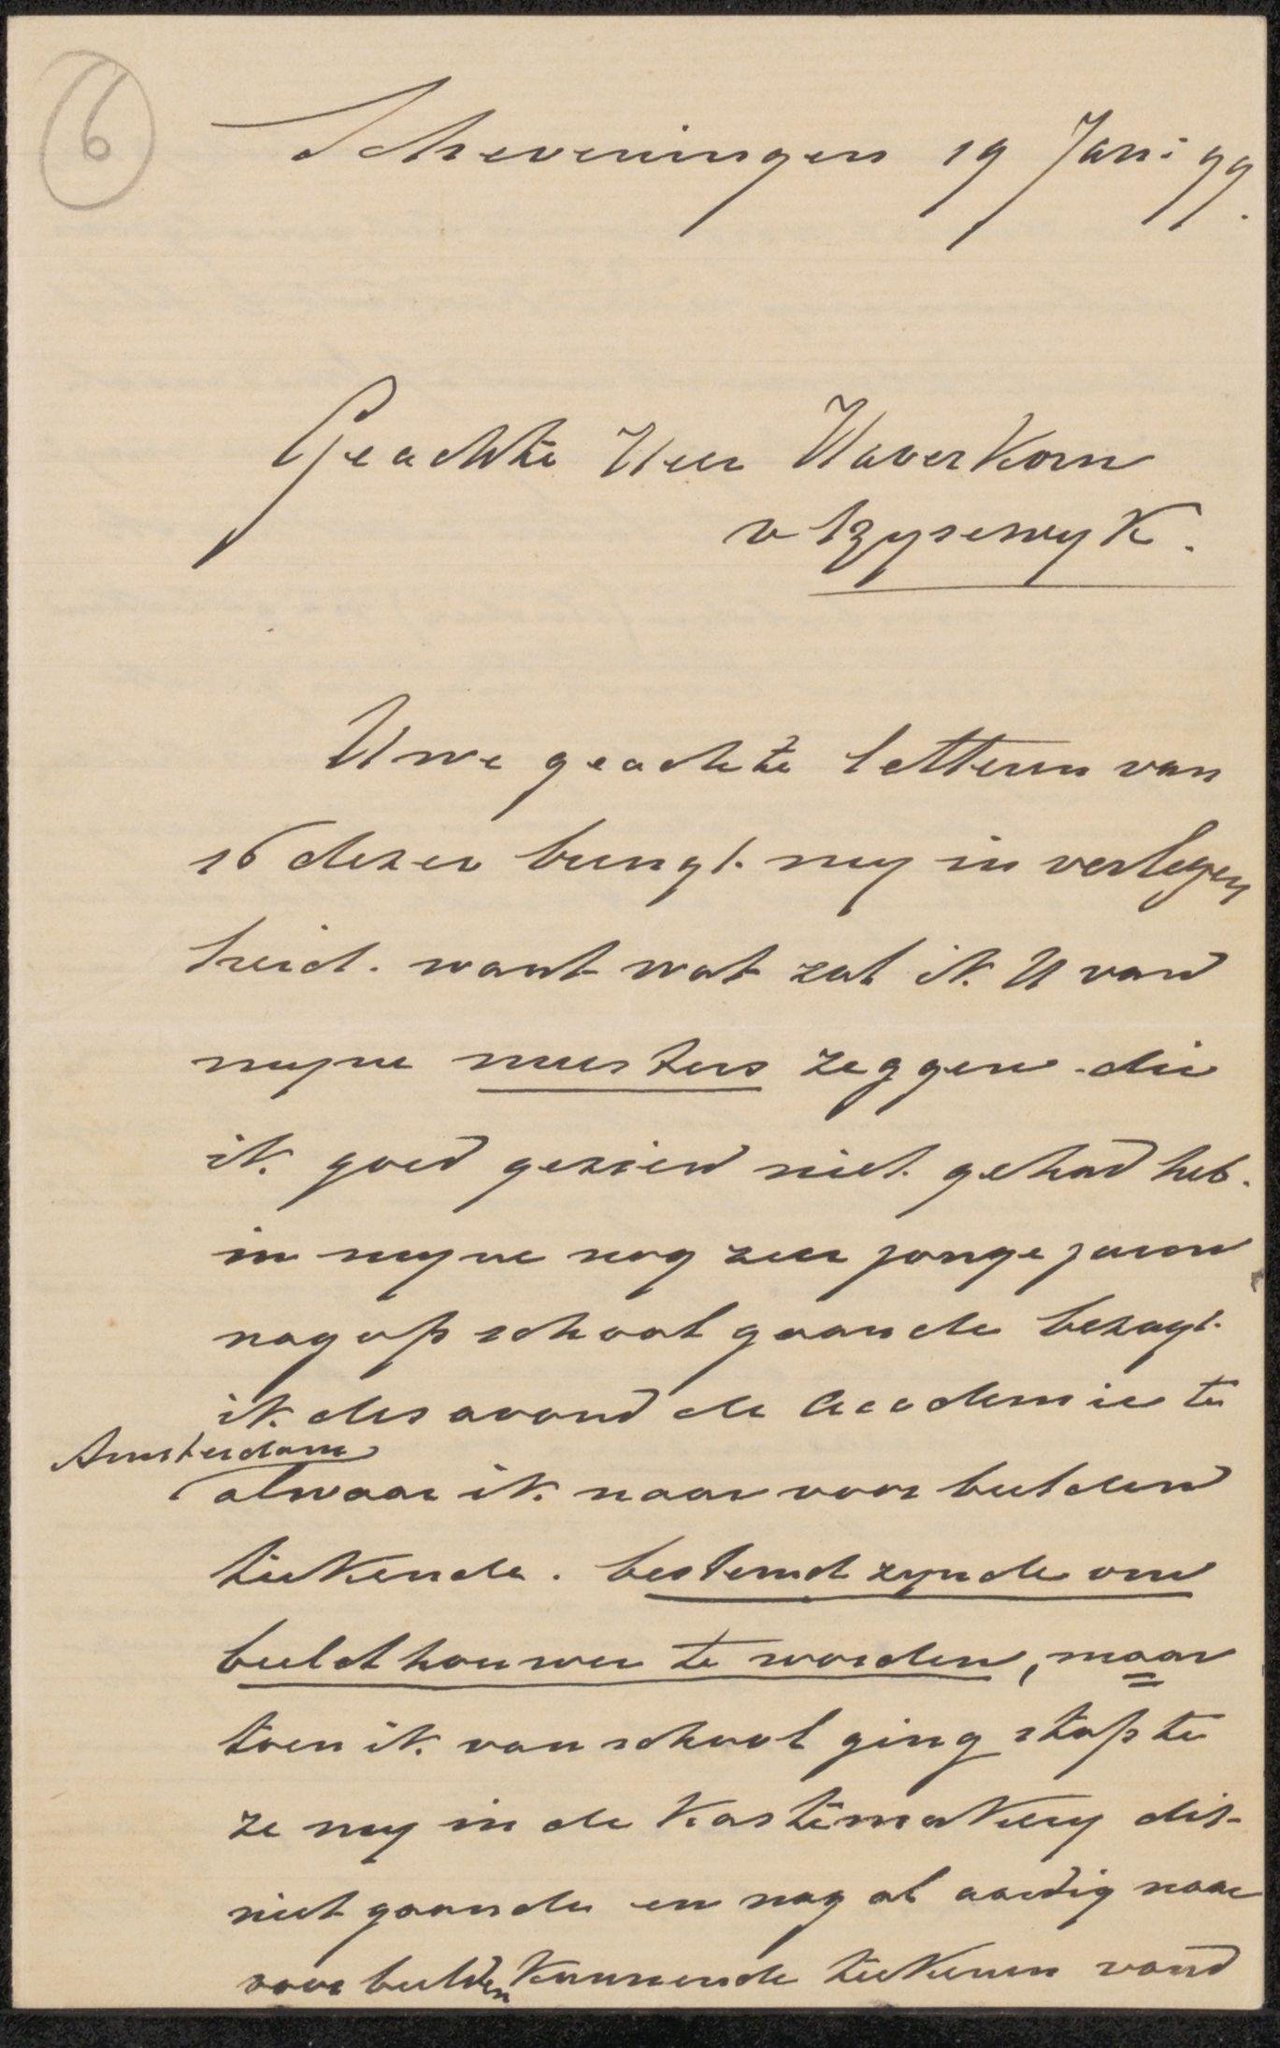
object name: letter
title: Brief aan Pieter Haverkorn van Rijsewijk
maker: paul joseph constantin gabriël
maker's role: draughtsman, print maker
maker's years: 1828-1903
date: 1899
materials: ink, paper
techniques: pen, writing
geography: scheveningen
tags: jeronimo de vries, amsterdam, willem roelofs (i), bruges, brussels, paul jean clays, middelburg, cleves, painter, print maker, draughtsman, barend cornelis koekkoek, pieter haverkorn van rijsewijk, louis paul zocher, drawing, sculpture, education, tuition of the artist (in general), painting (including book-illumination, miniature-painting), physiognomy, diseases, artist at work, in his workshop - bb - out of doors, historical persons (portraits and scenes from the life), money, haarlem, paris, switzerland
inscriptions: watermark